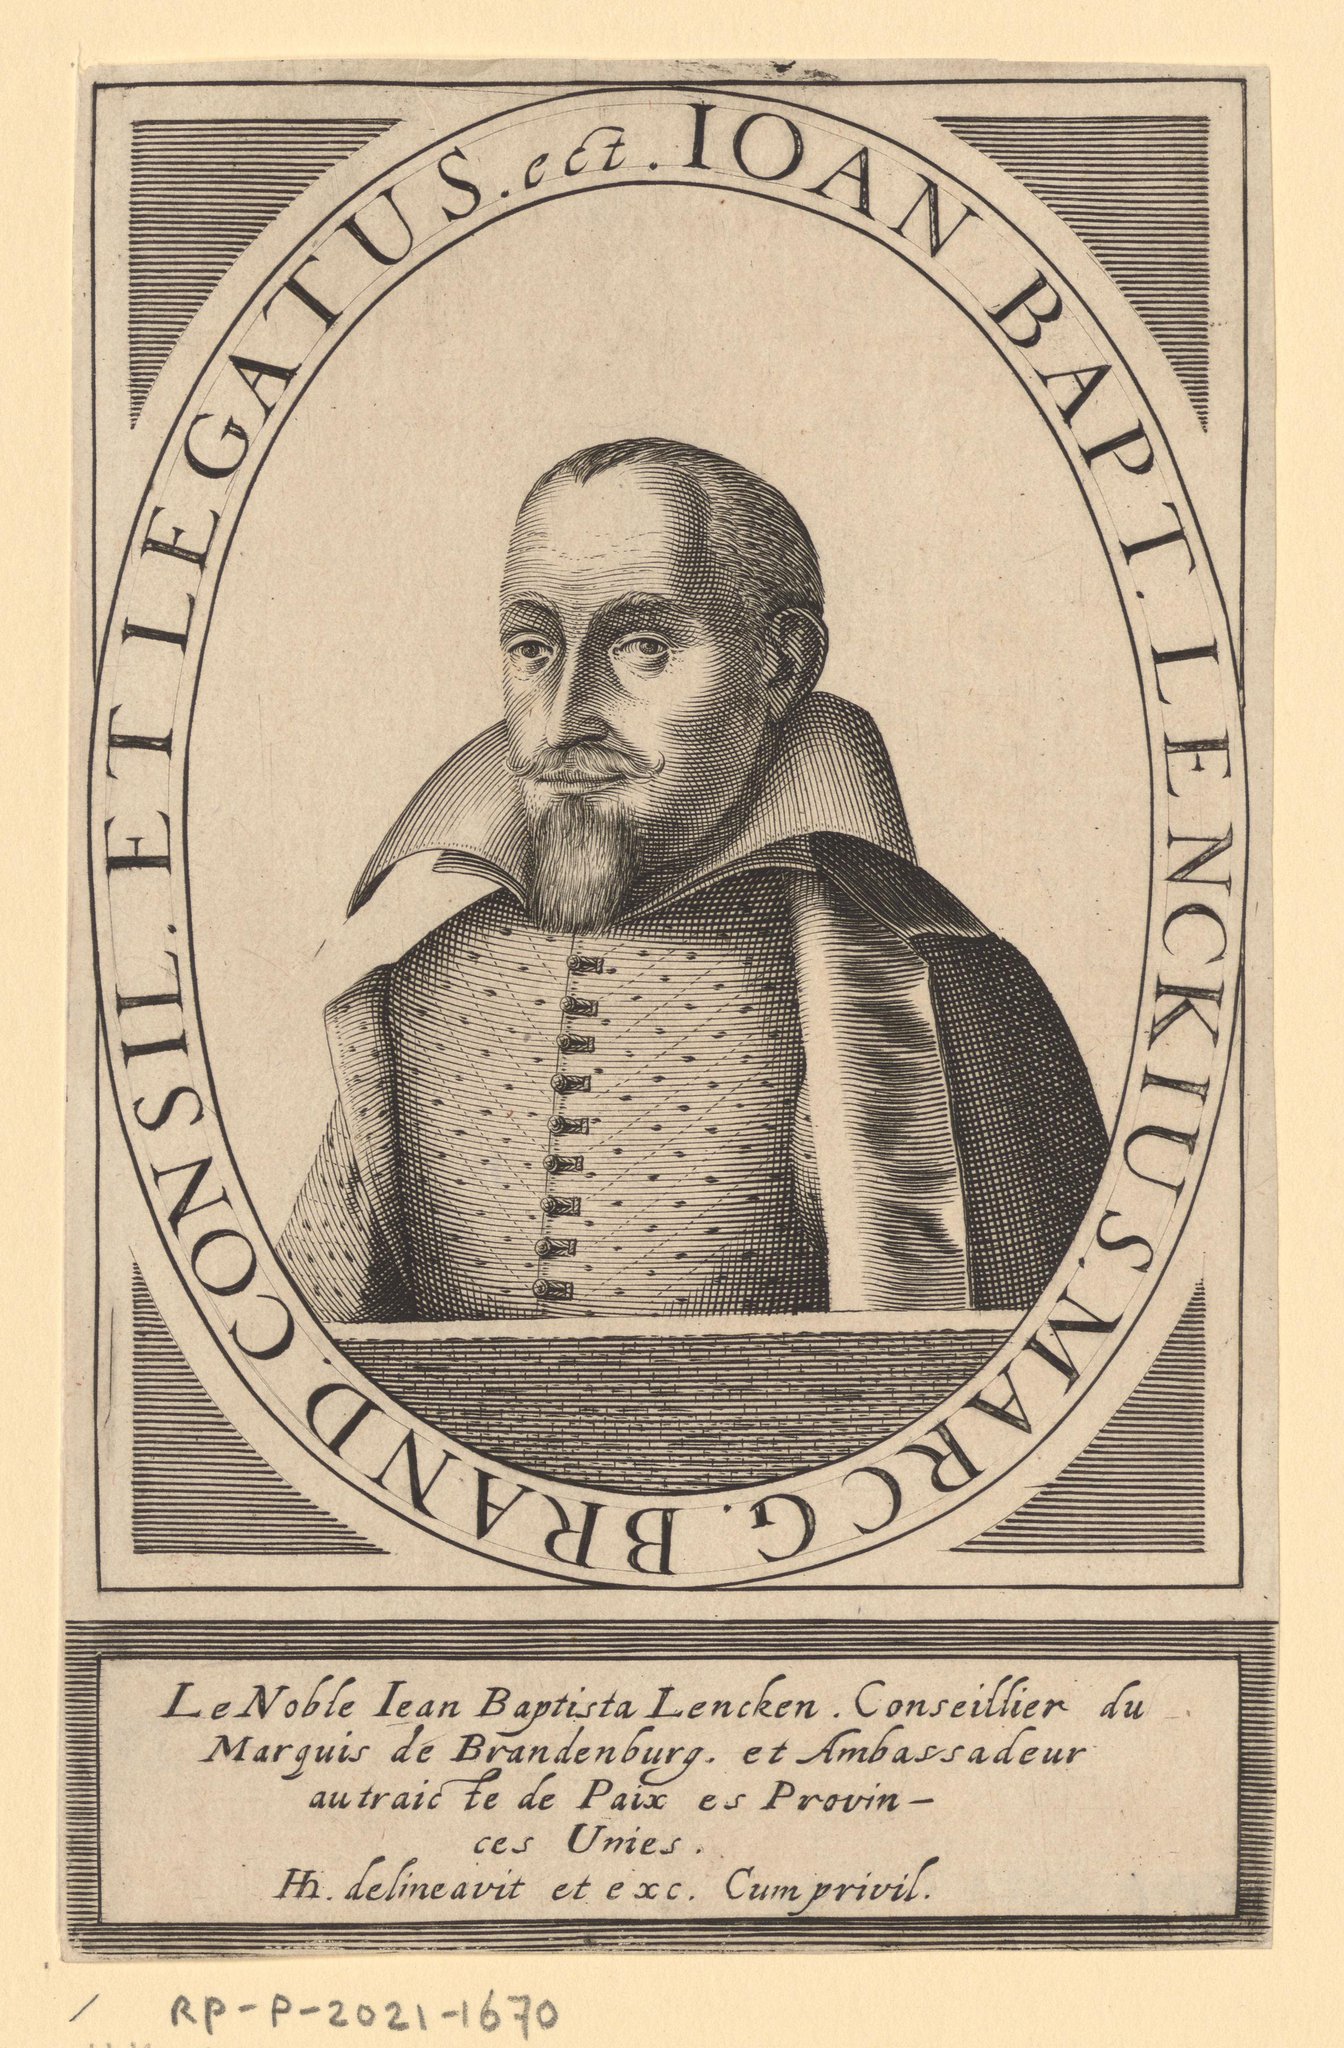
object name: print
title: Portret van Johann Baptist Lenck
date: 1608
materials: paper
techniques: engraving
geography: the hague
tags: politician, historical persons, ambassador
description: Met tekst in het Latijn rondom het portret en tekst in het Frans onder het portret.